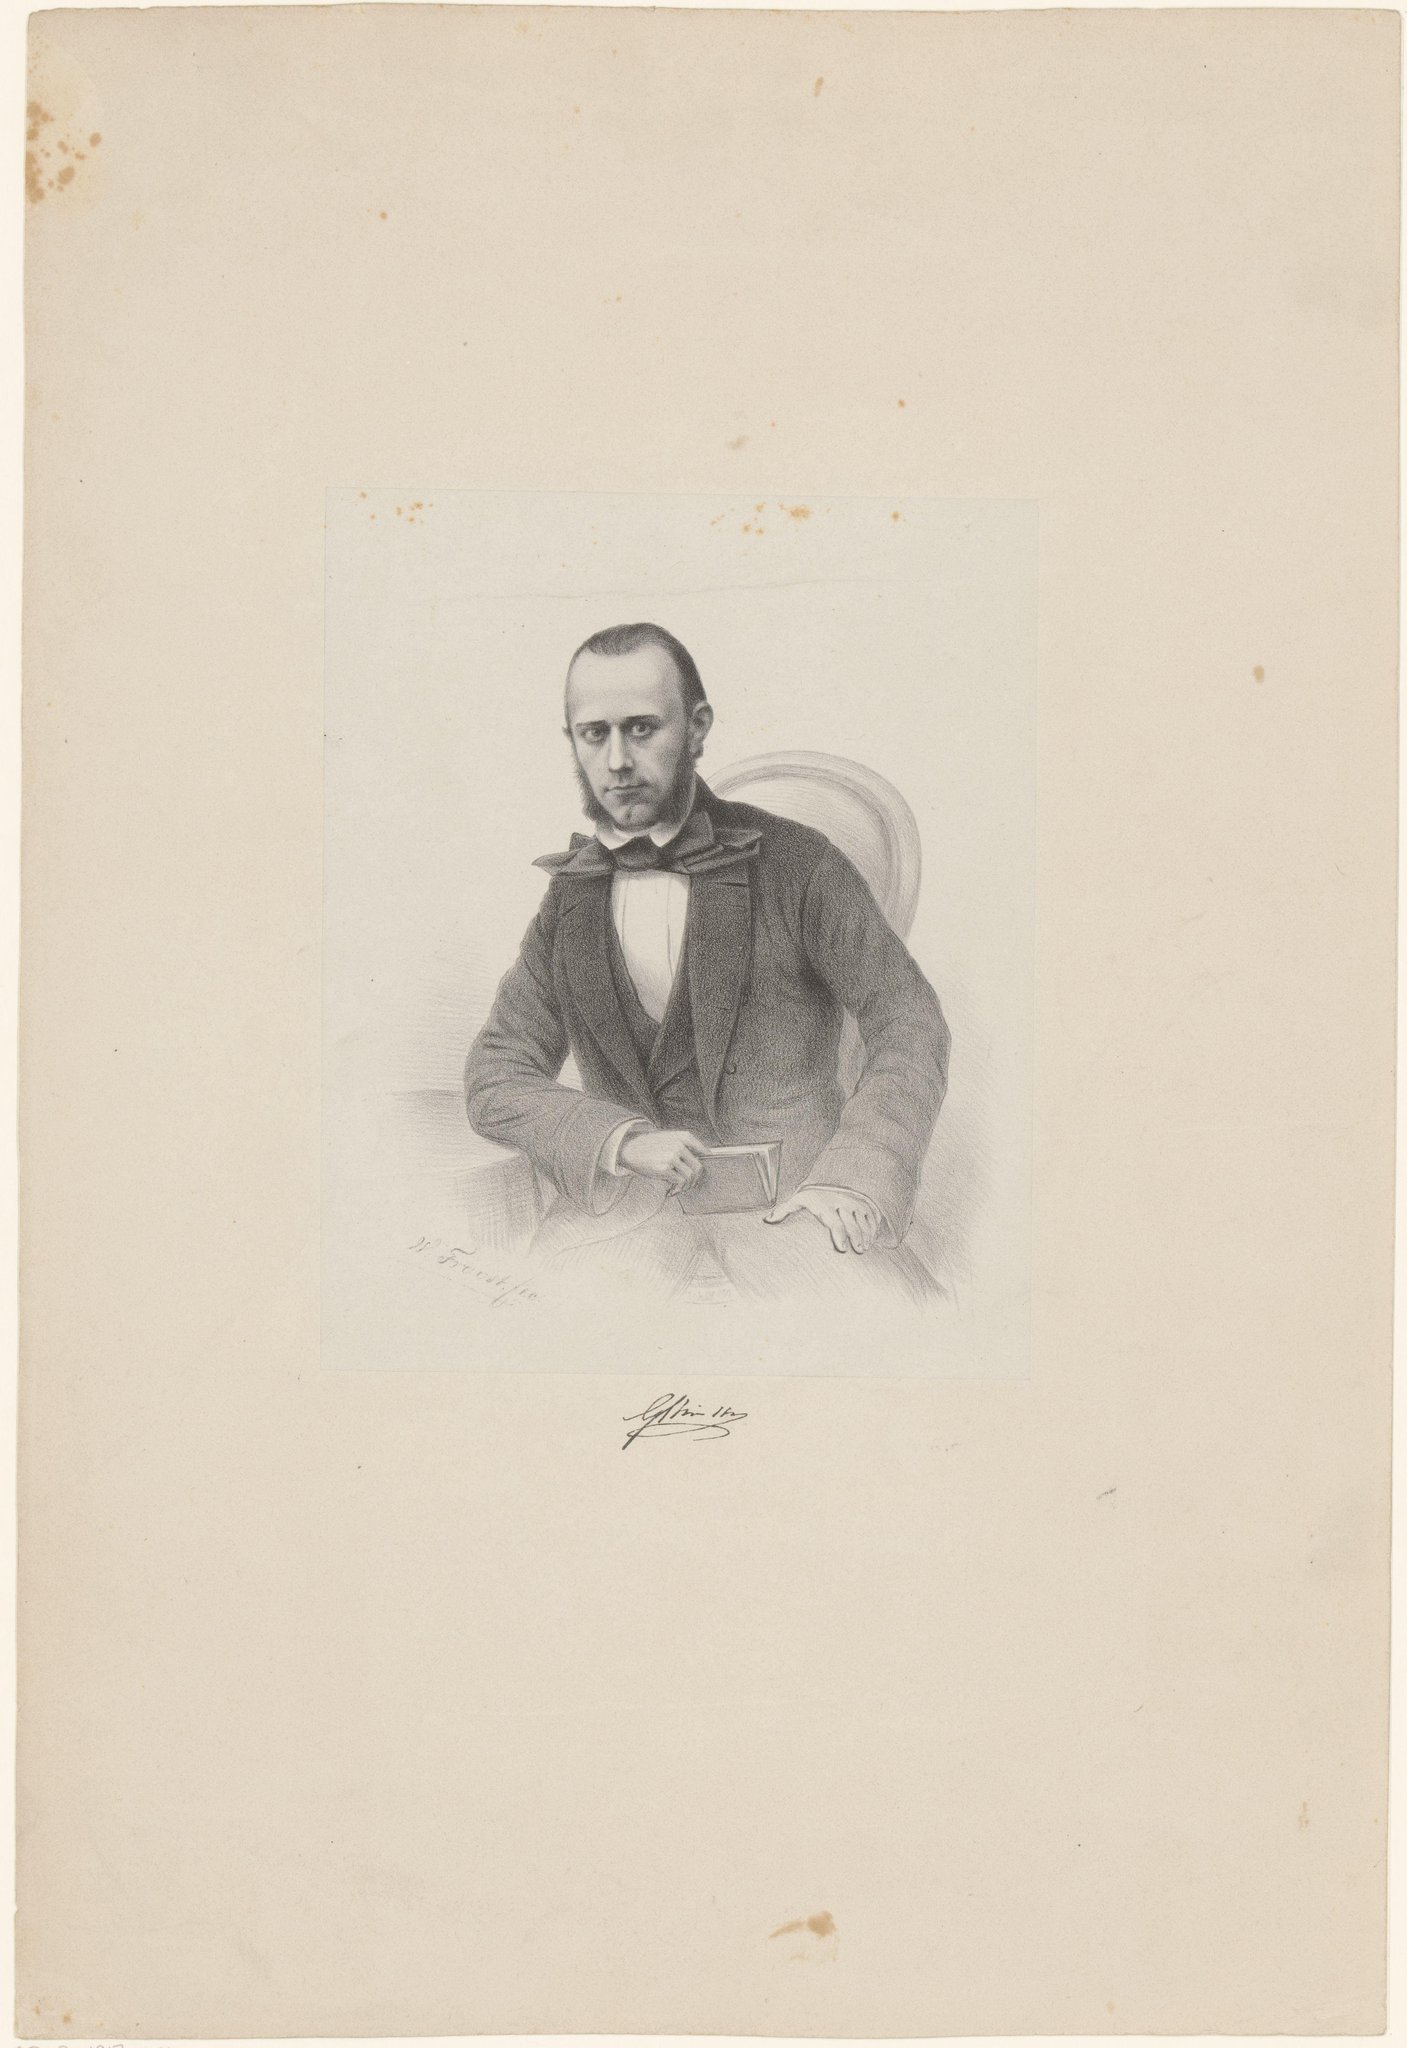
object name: print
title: Portret van onbekende man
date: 1822-1893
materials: paper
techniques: lithograph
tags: historical persons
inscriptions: collector's mark: Lugt 2228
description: Onder het portret de signatuur van de geportretteerde.